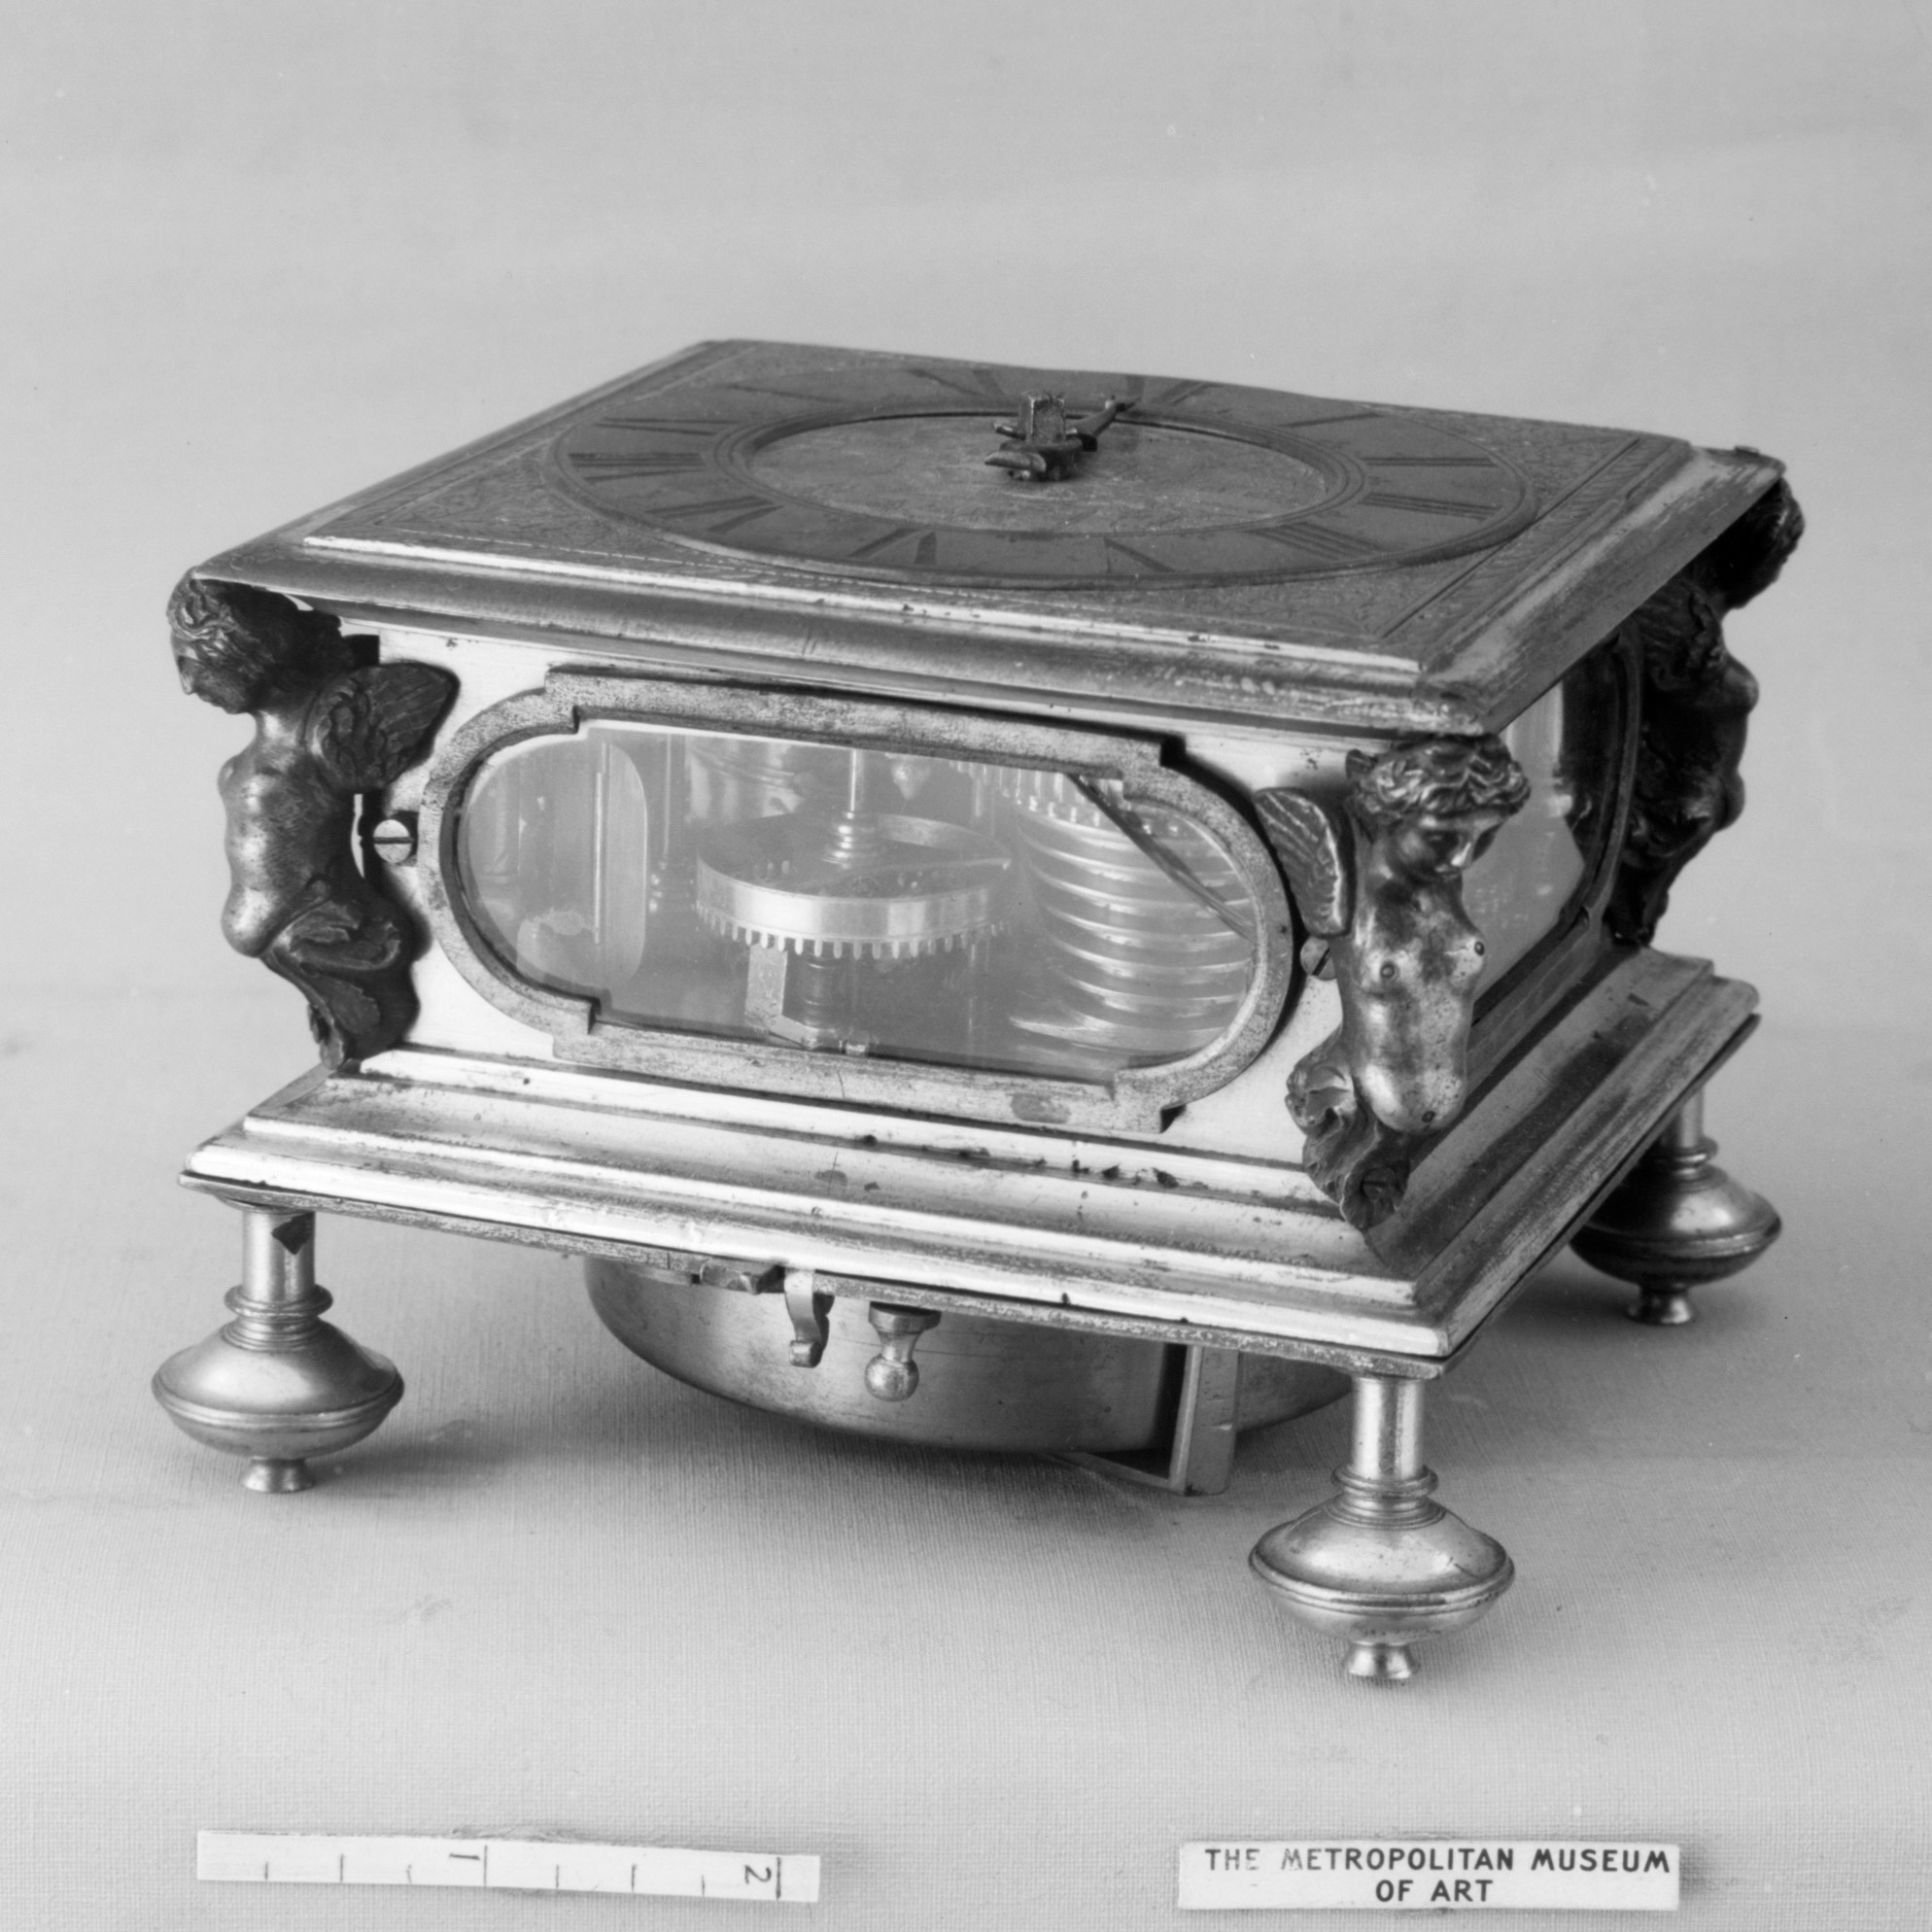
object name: table clock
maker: daniel picardi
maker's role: maker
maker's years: 1600-1700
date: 1601-1700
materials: brass, gilt, glass, silver, steel